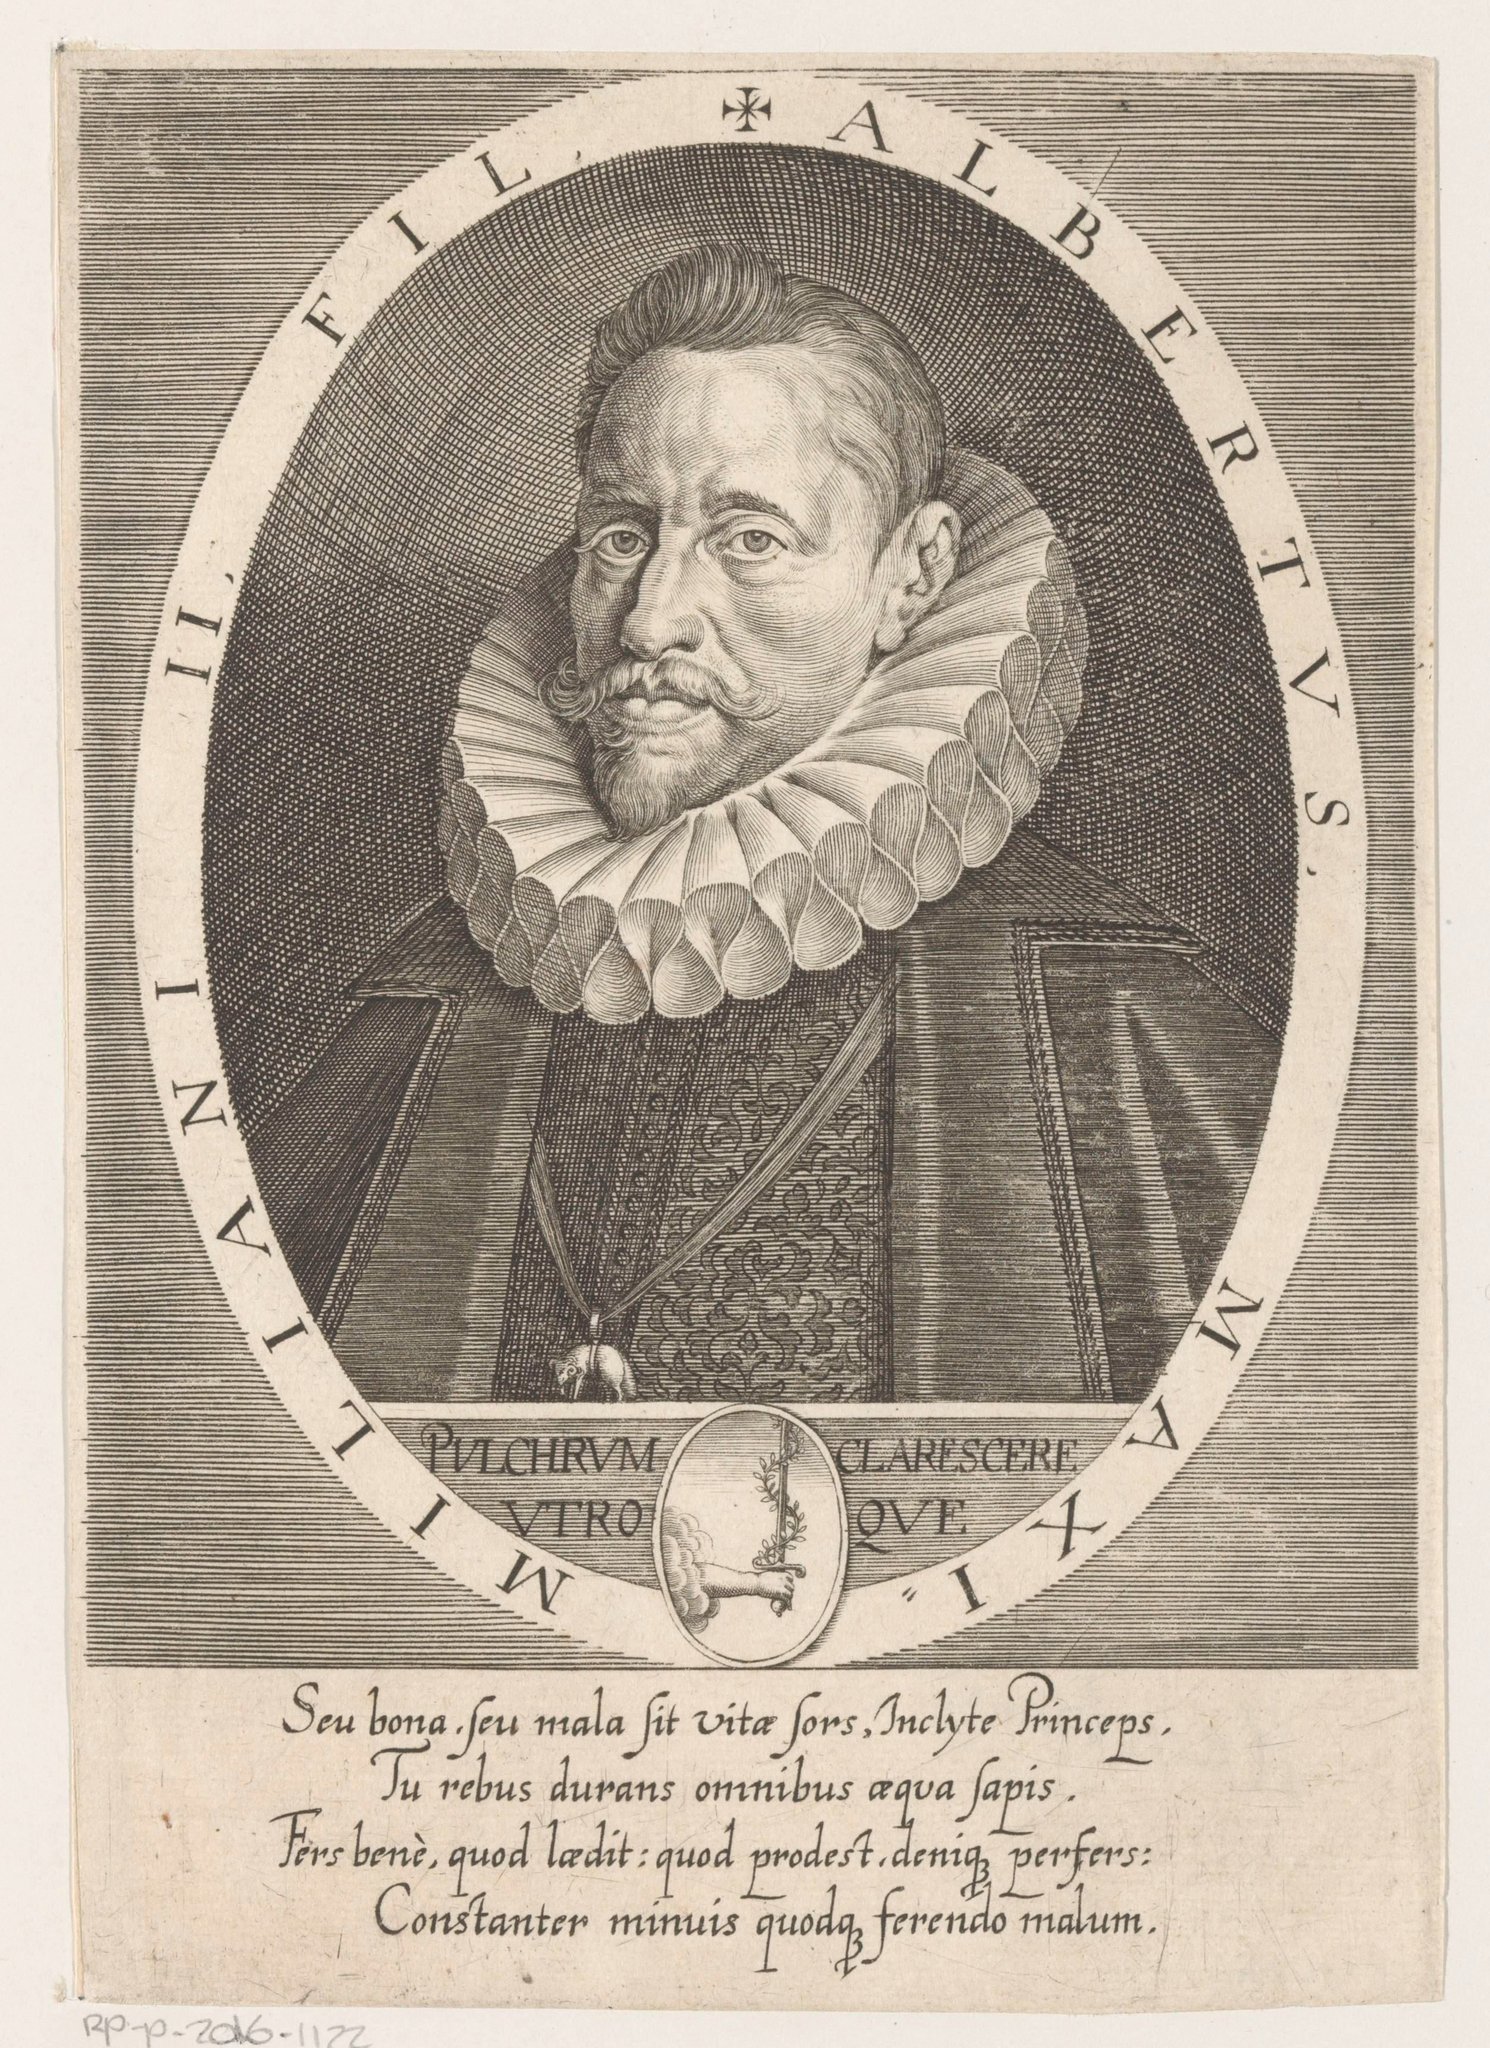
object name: print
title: Portret van Albrecht, aartshertog van Oostenrijk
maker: Anonymous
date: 1600-1699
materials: paper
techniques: engraving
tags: brussels, albrecht aartshertog van oostenrijk, knighthood order of the golden fleece - insignia of a knighthood order, e.g.: badge, chain (with name of order)